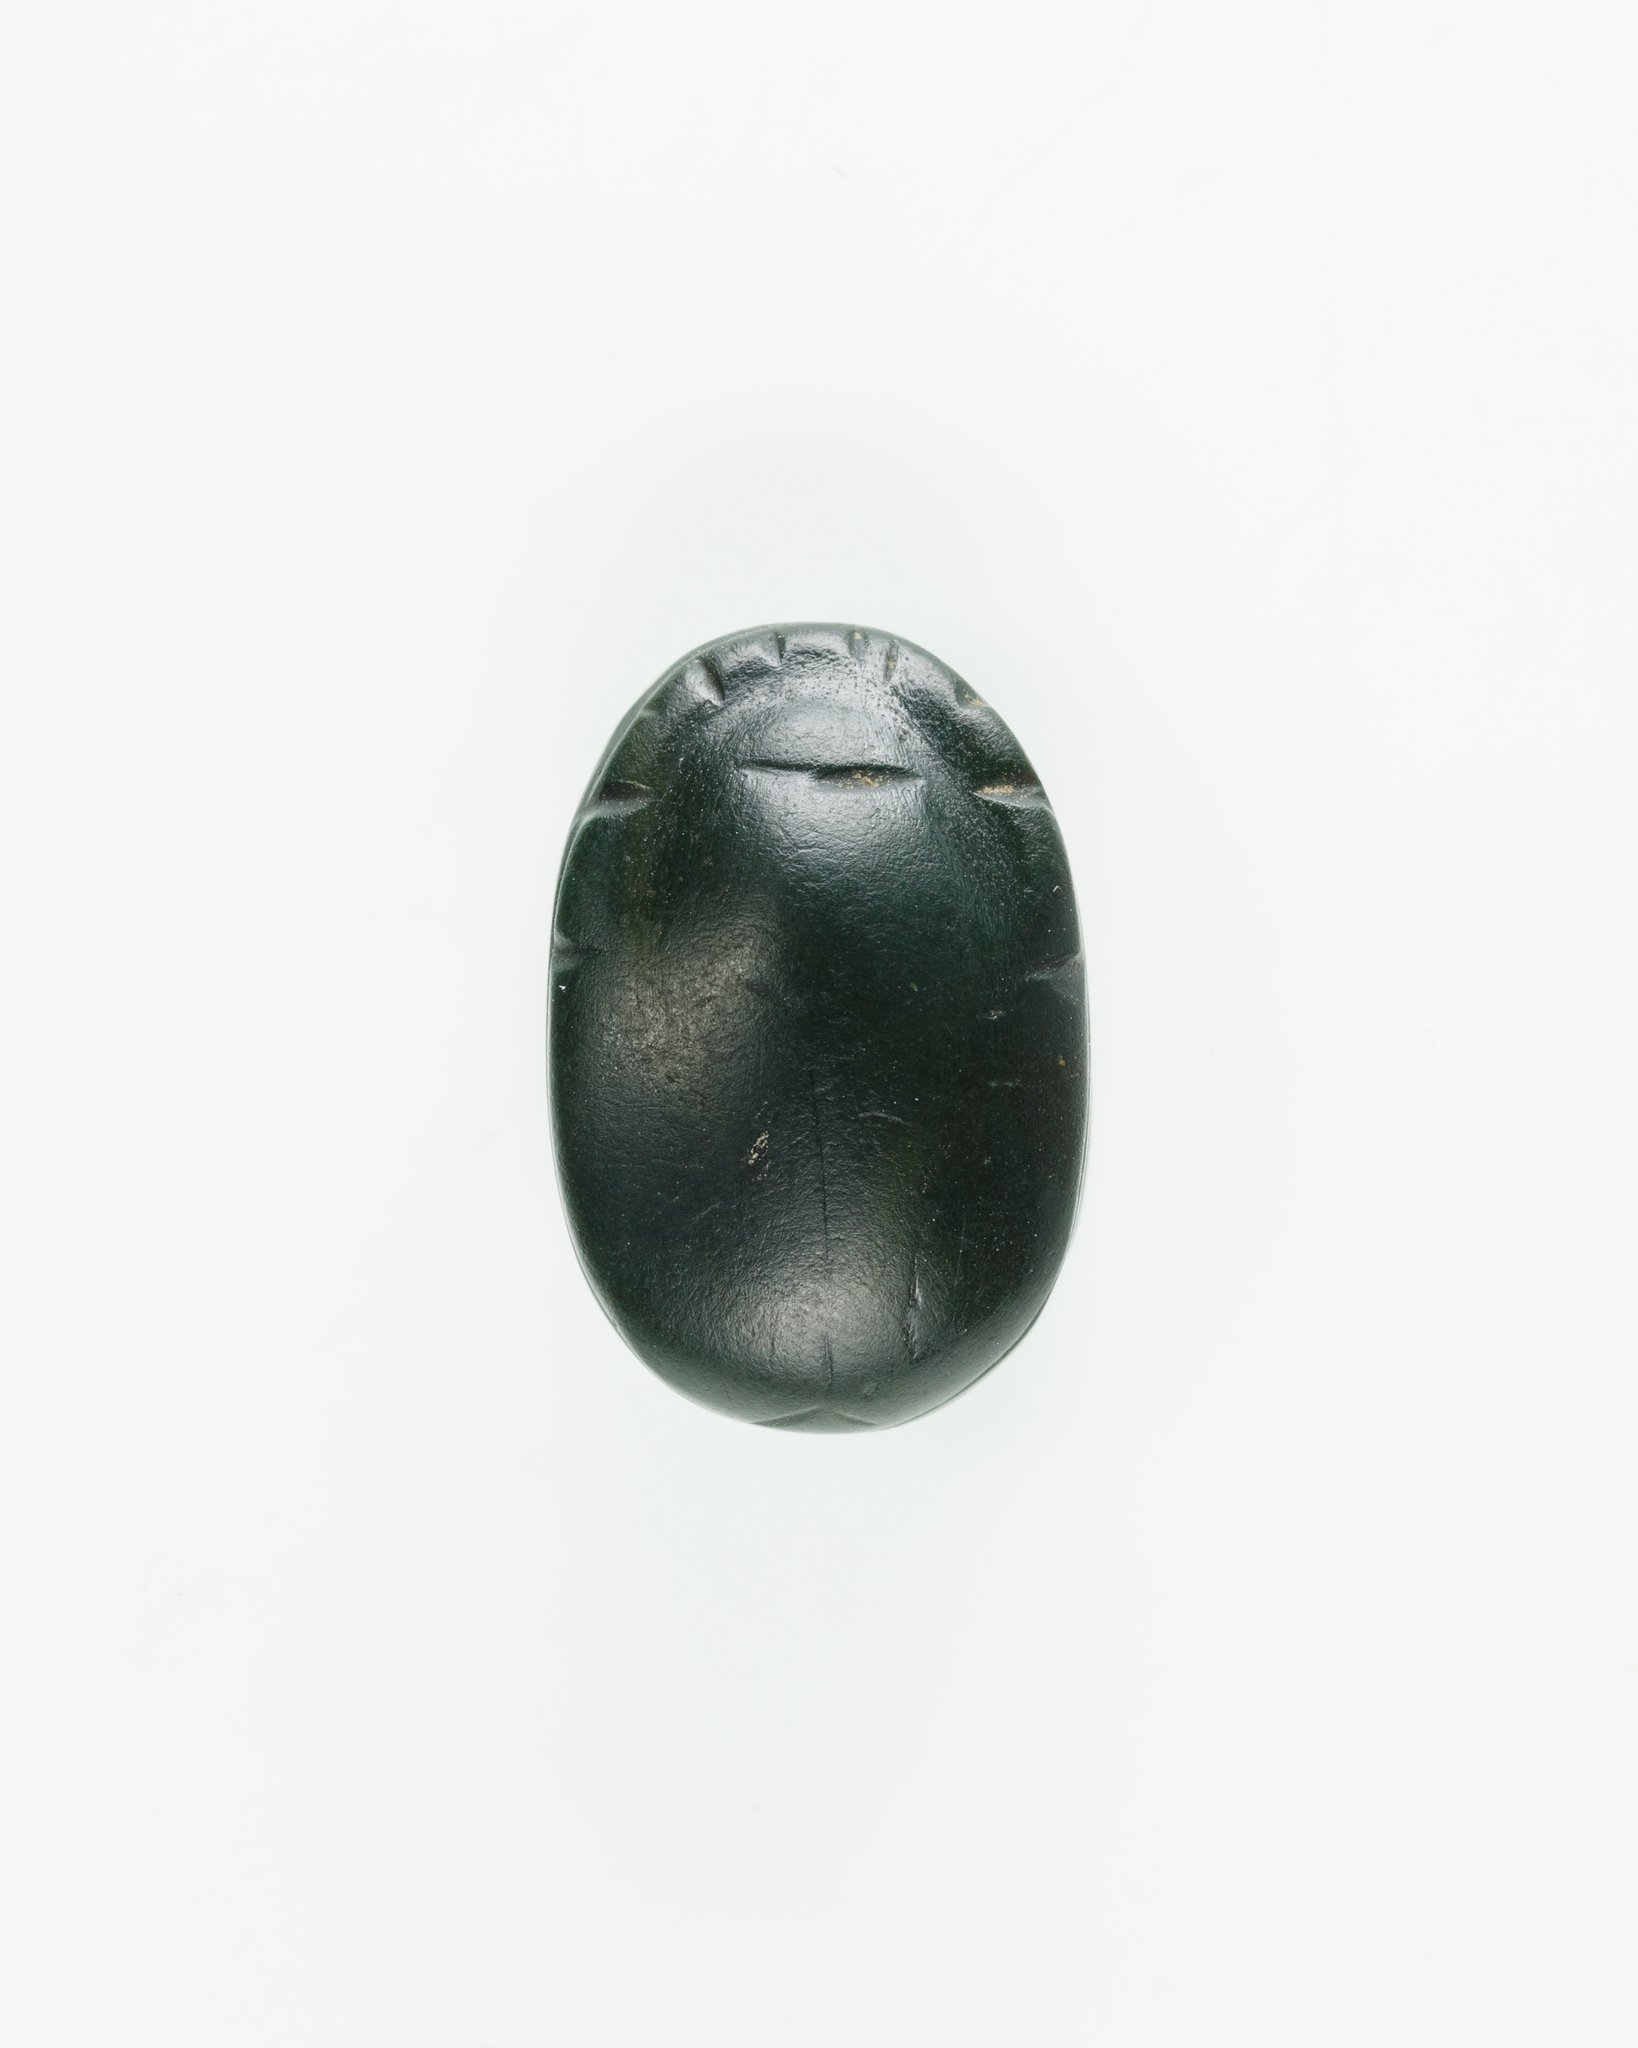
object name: scarab, uninscribed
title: Uninscribed scarab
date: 1981-1640 BCE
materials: jasper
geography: egypt